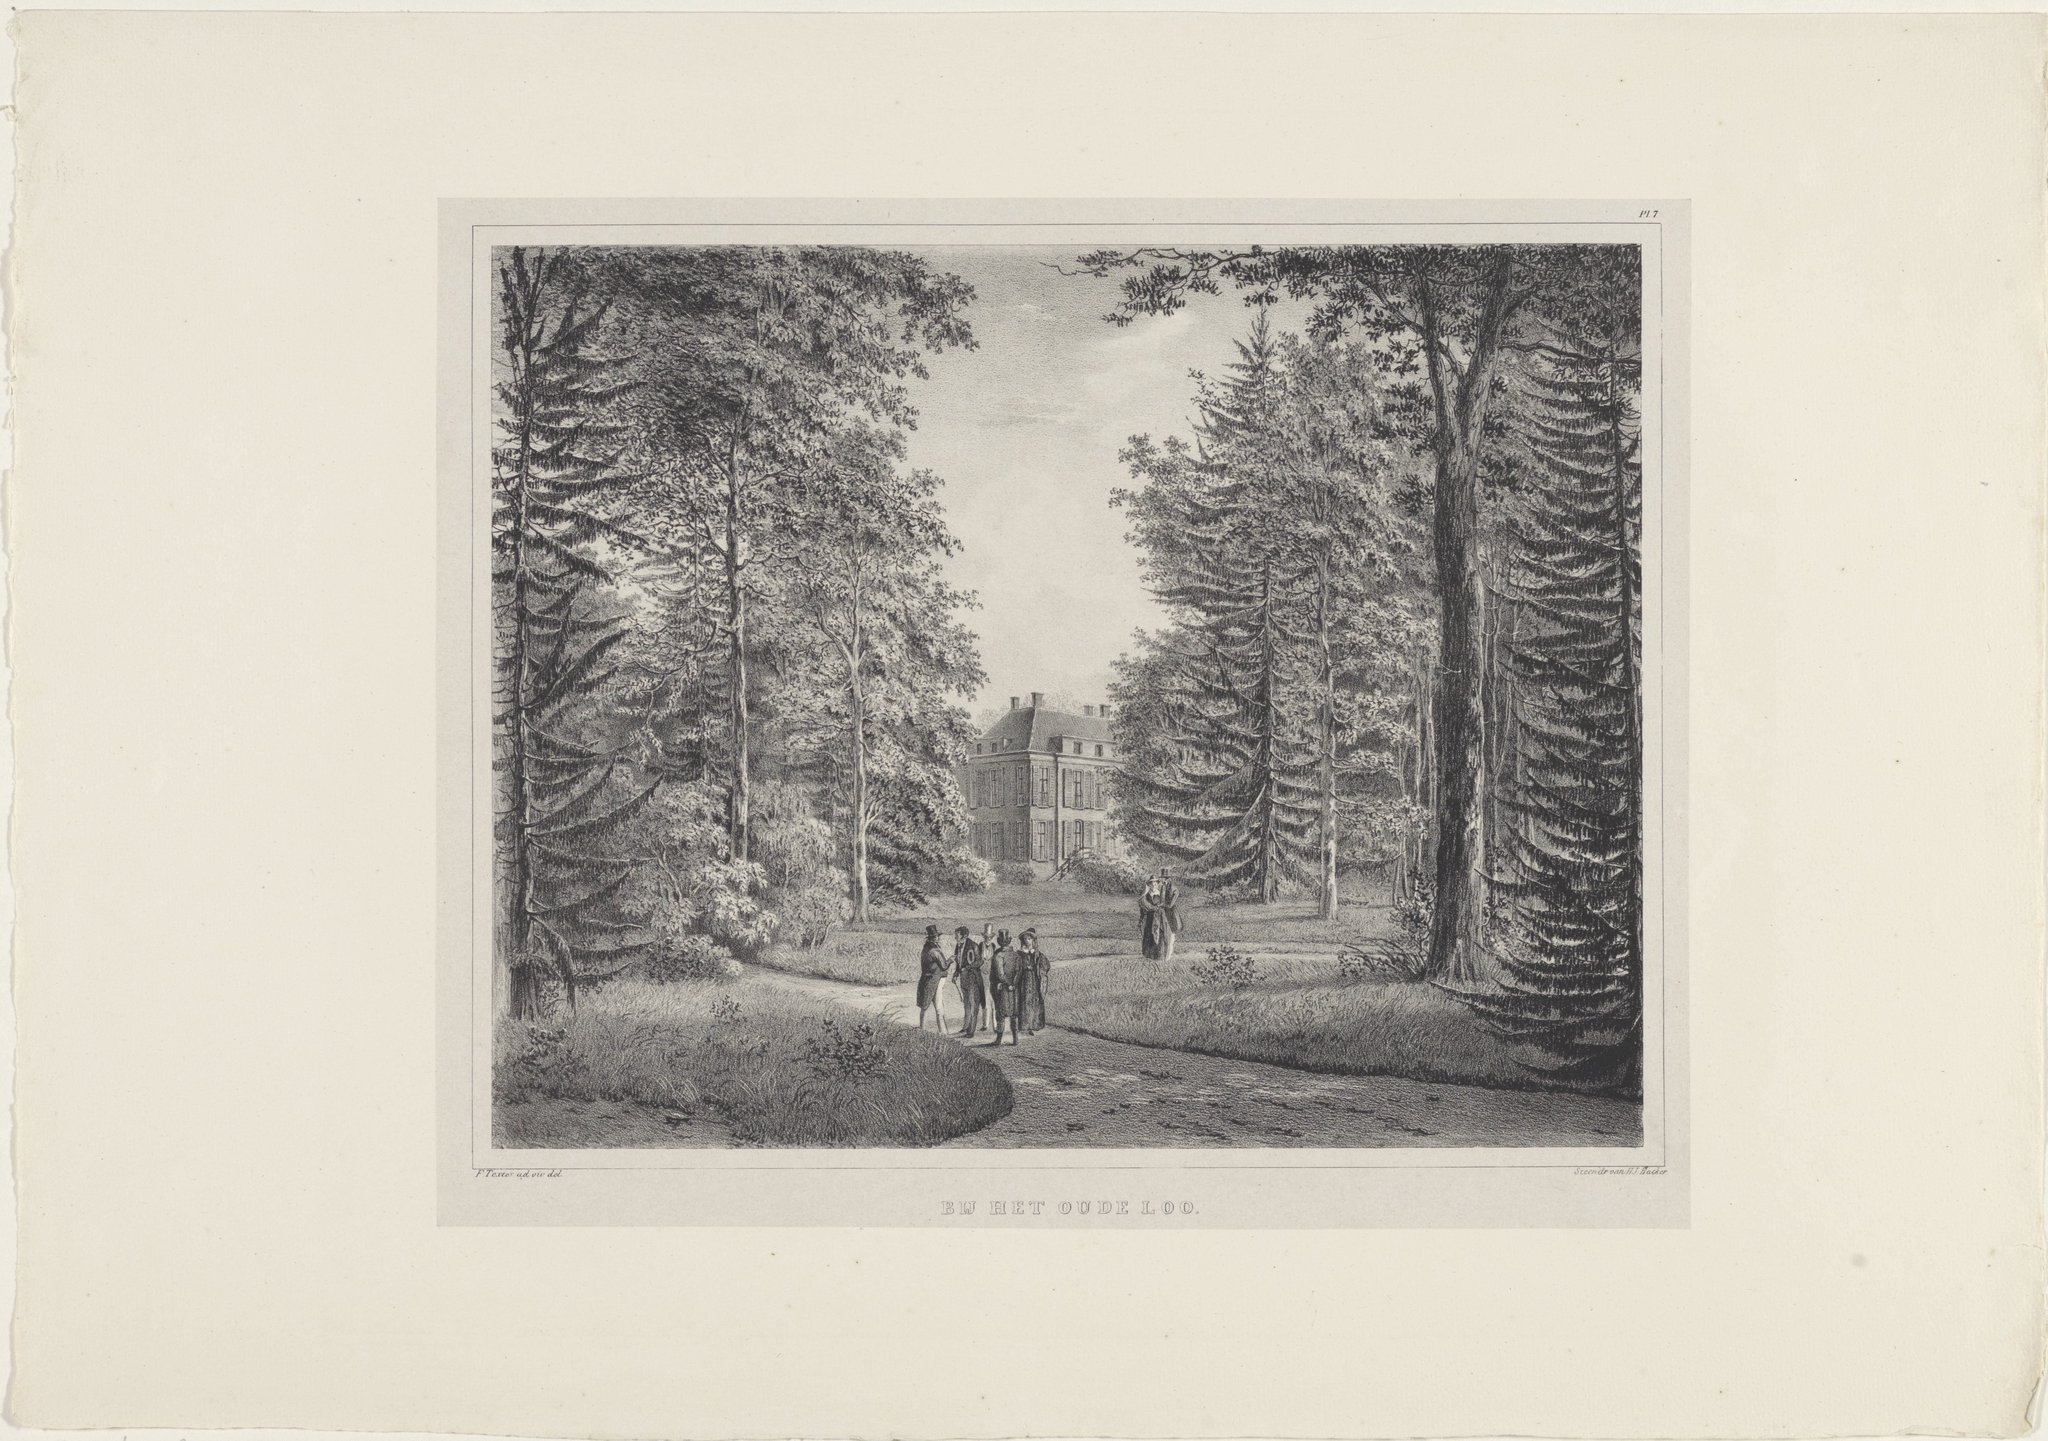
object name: print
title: XII Gezigten in het Park Het Loo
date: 1822-1845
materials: paper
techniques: lithograph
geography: the hague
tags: park, strolling, palace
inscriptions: collector's mark: Lugt 2228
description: Tussen de bomen is een deel van het Oude Loo zichtbaar. Op een pad staat een groepje heren en een dame. Een dame en heer komen aangelopen. Genummerd rechtsboven: Pl. 7.